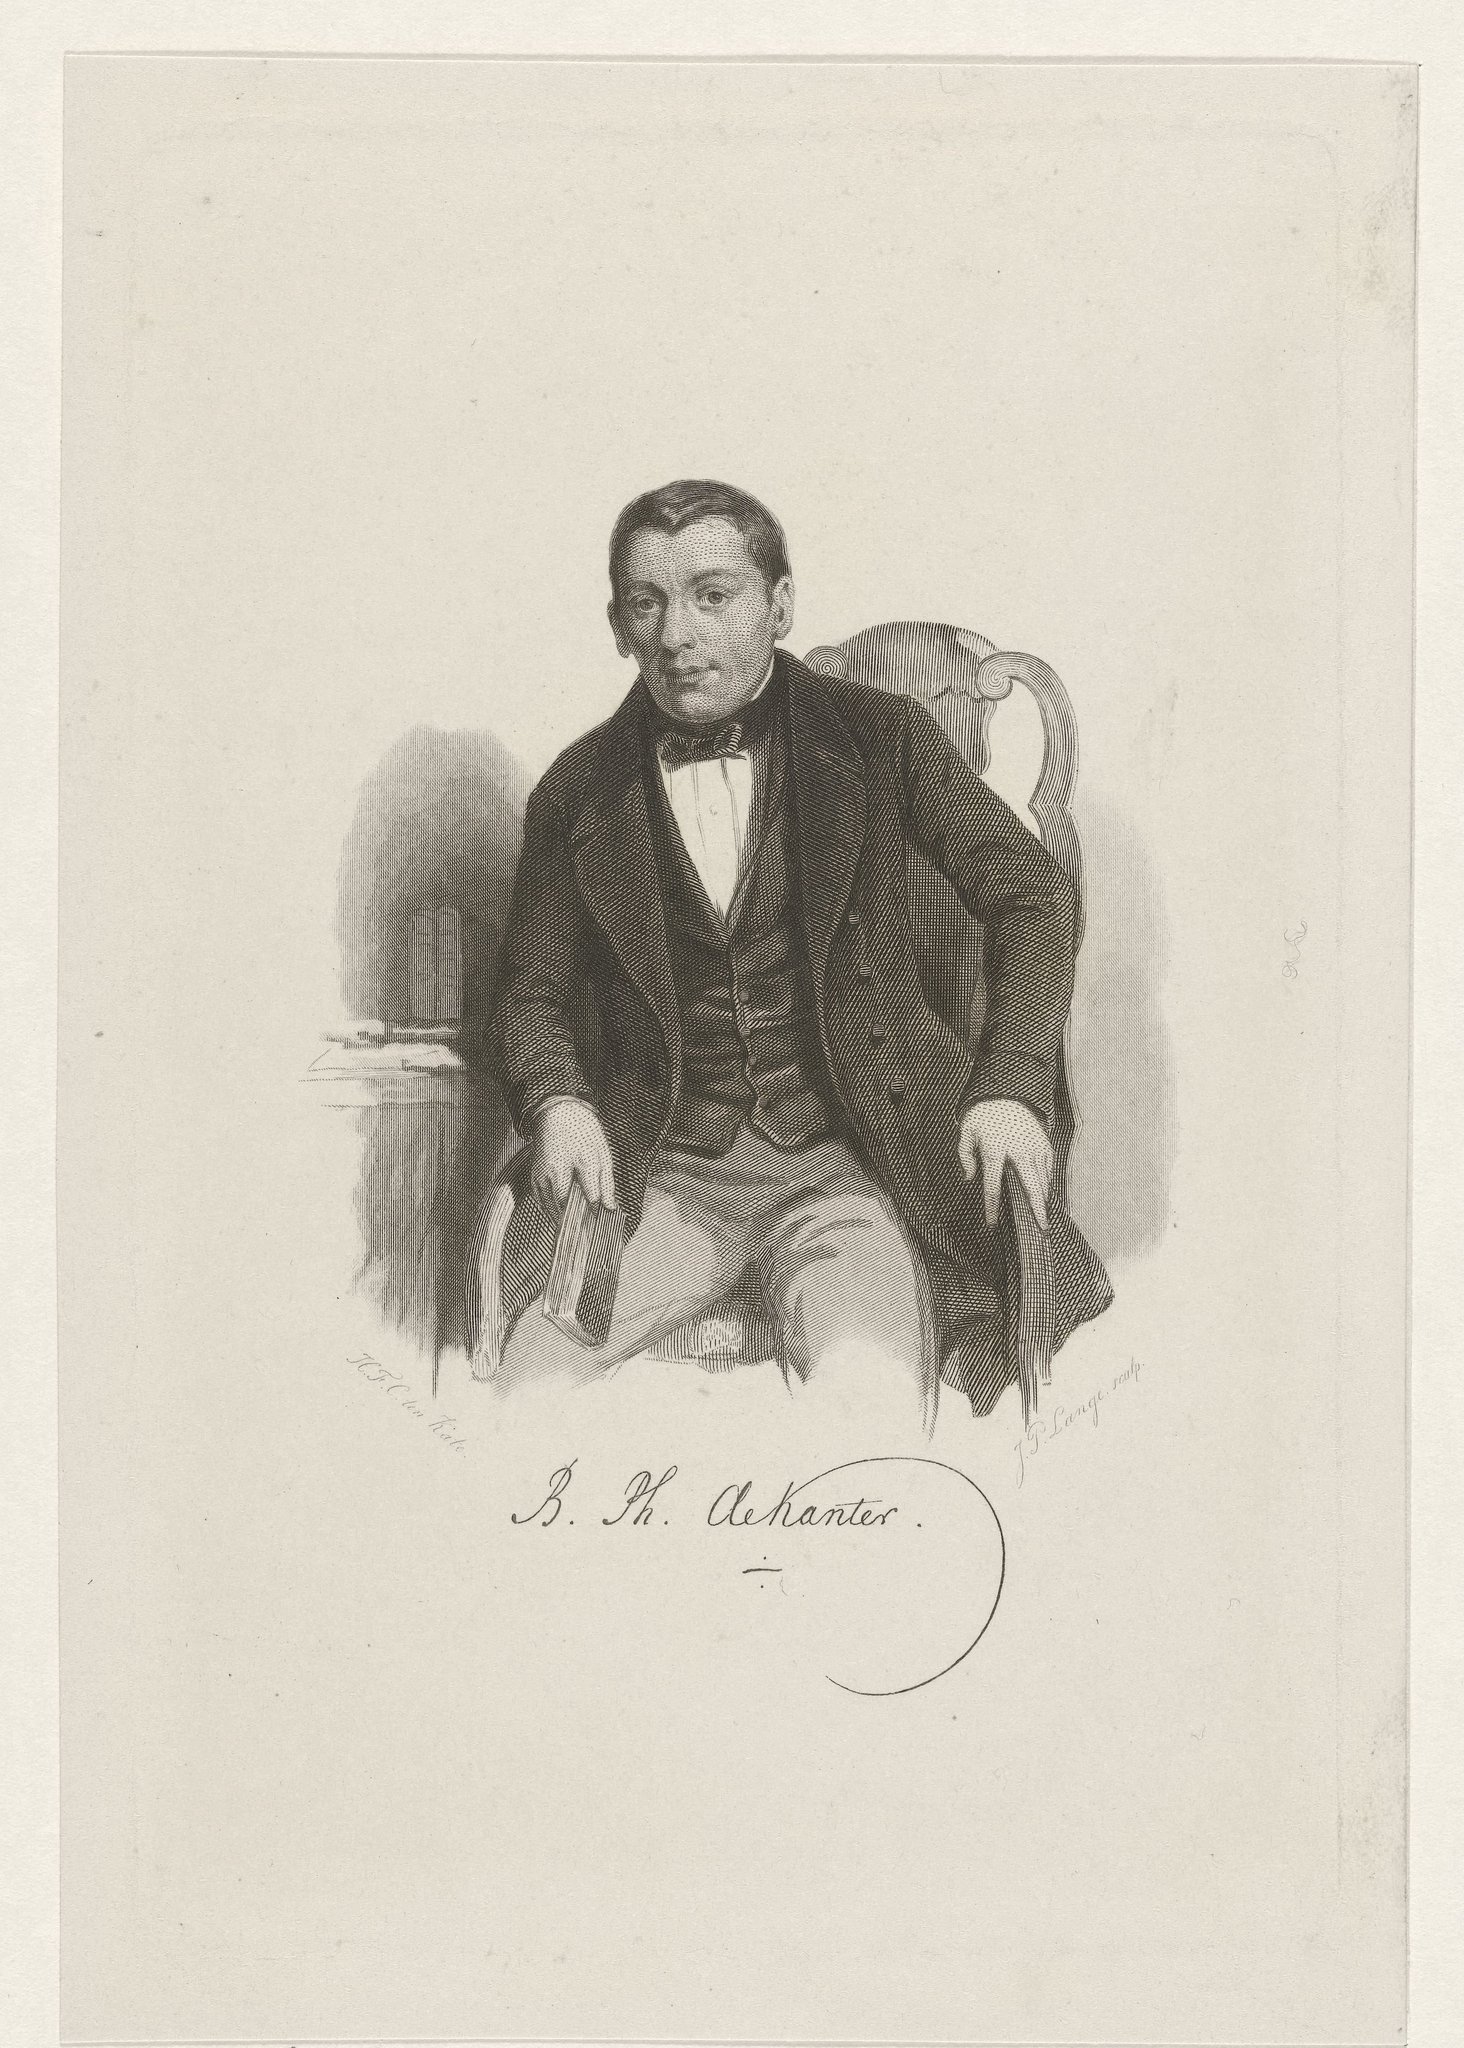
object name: print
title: Portret van Bartholomeus Philippus de Kanter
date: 1832-1849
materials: paper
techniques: engraving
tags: the hague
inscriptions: collector's mark: Lugt 2228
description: Portret van Bartholomeus Philippus de Kanter, staatsman en dichter. Kniestuk, zittend in een stoel met een boek in de hand.